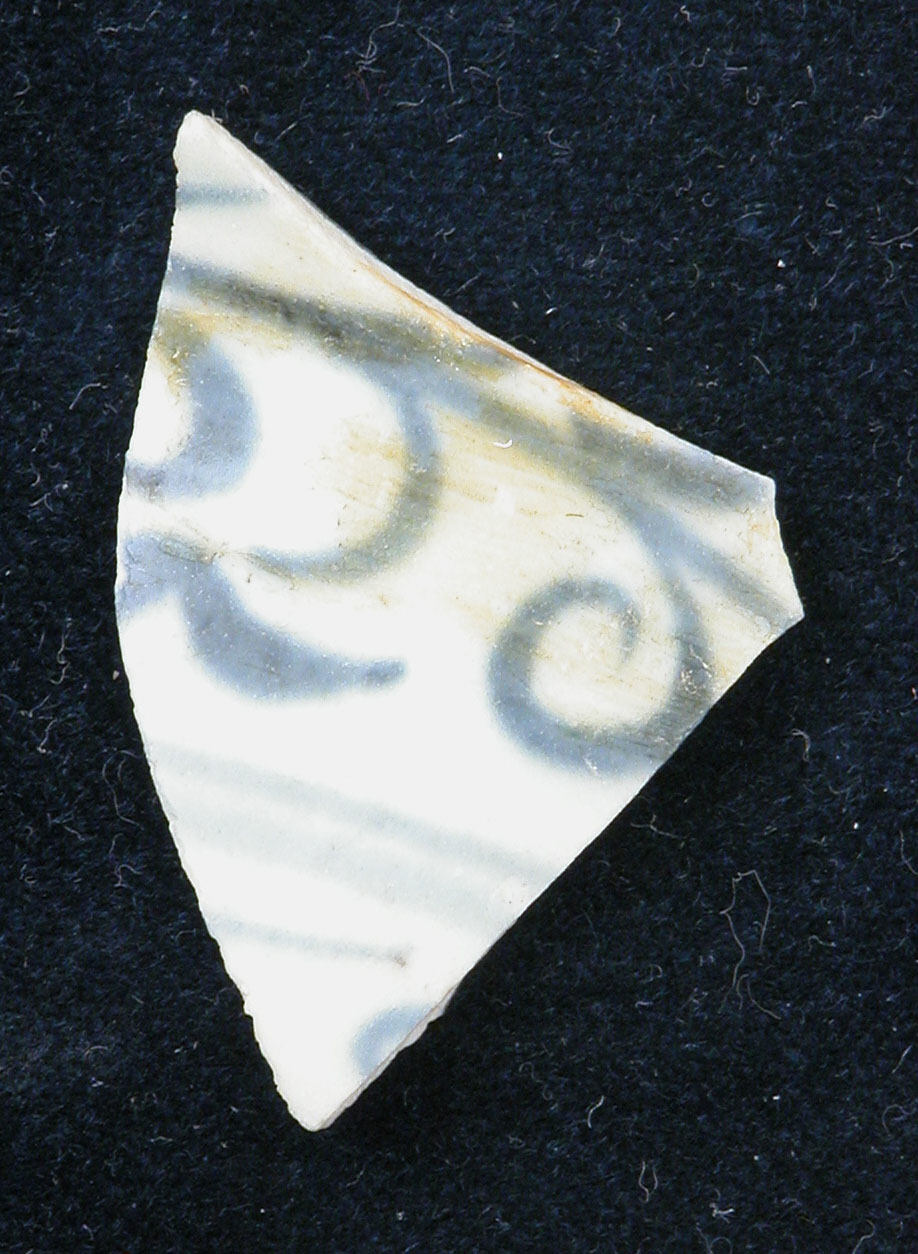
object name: fragment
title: Ceramic Fragment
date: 1201-1400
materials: porcelain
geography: saudi arabia